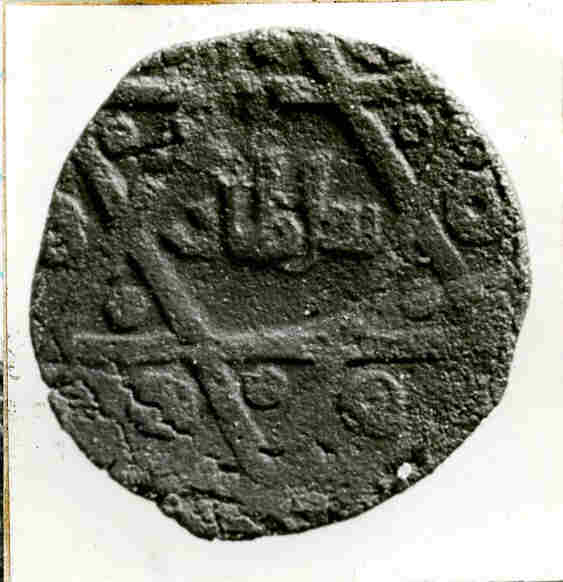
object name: coin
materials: copper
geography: iran